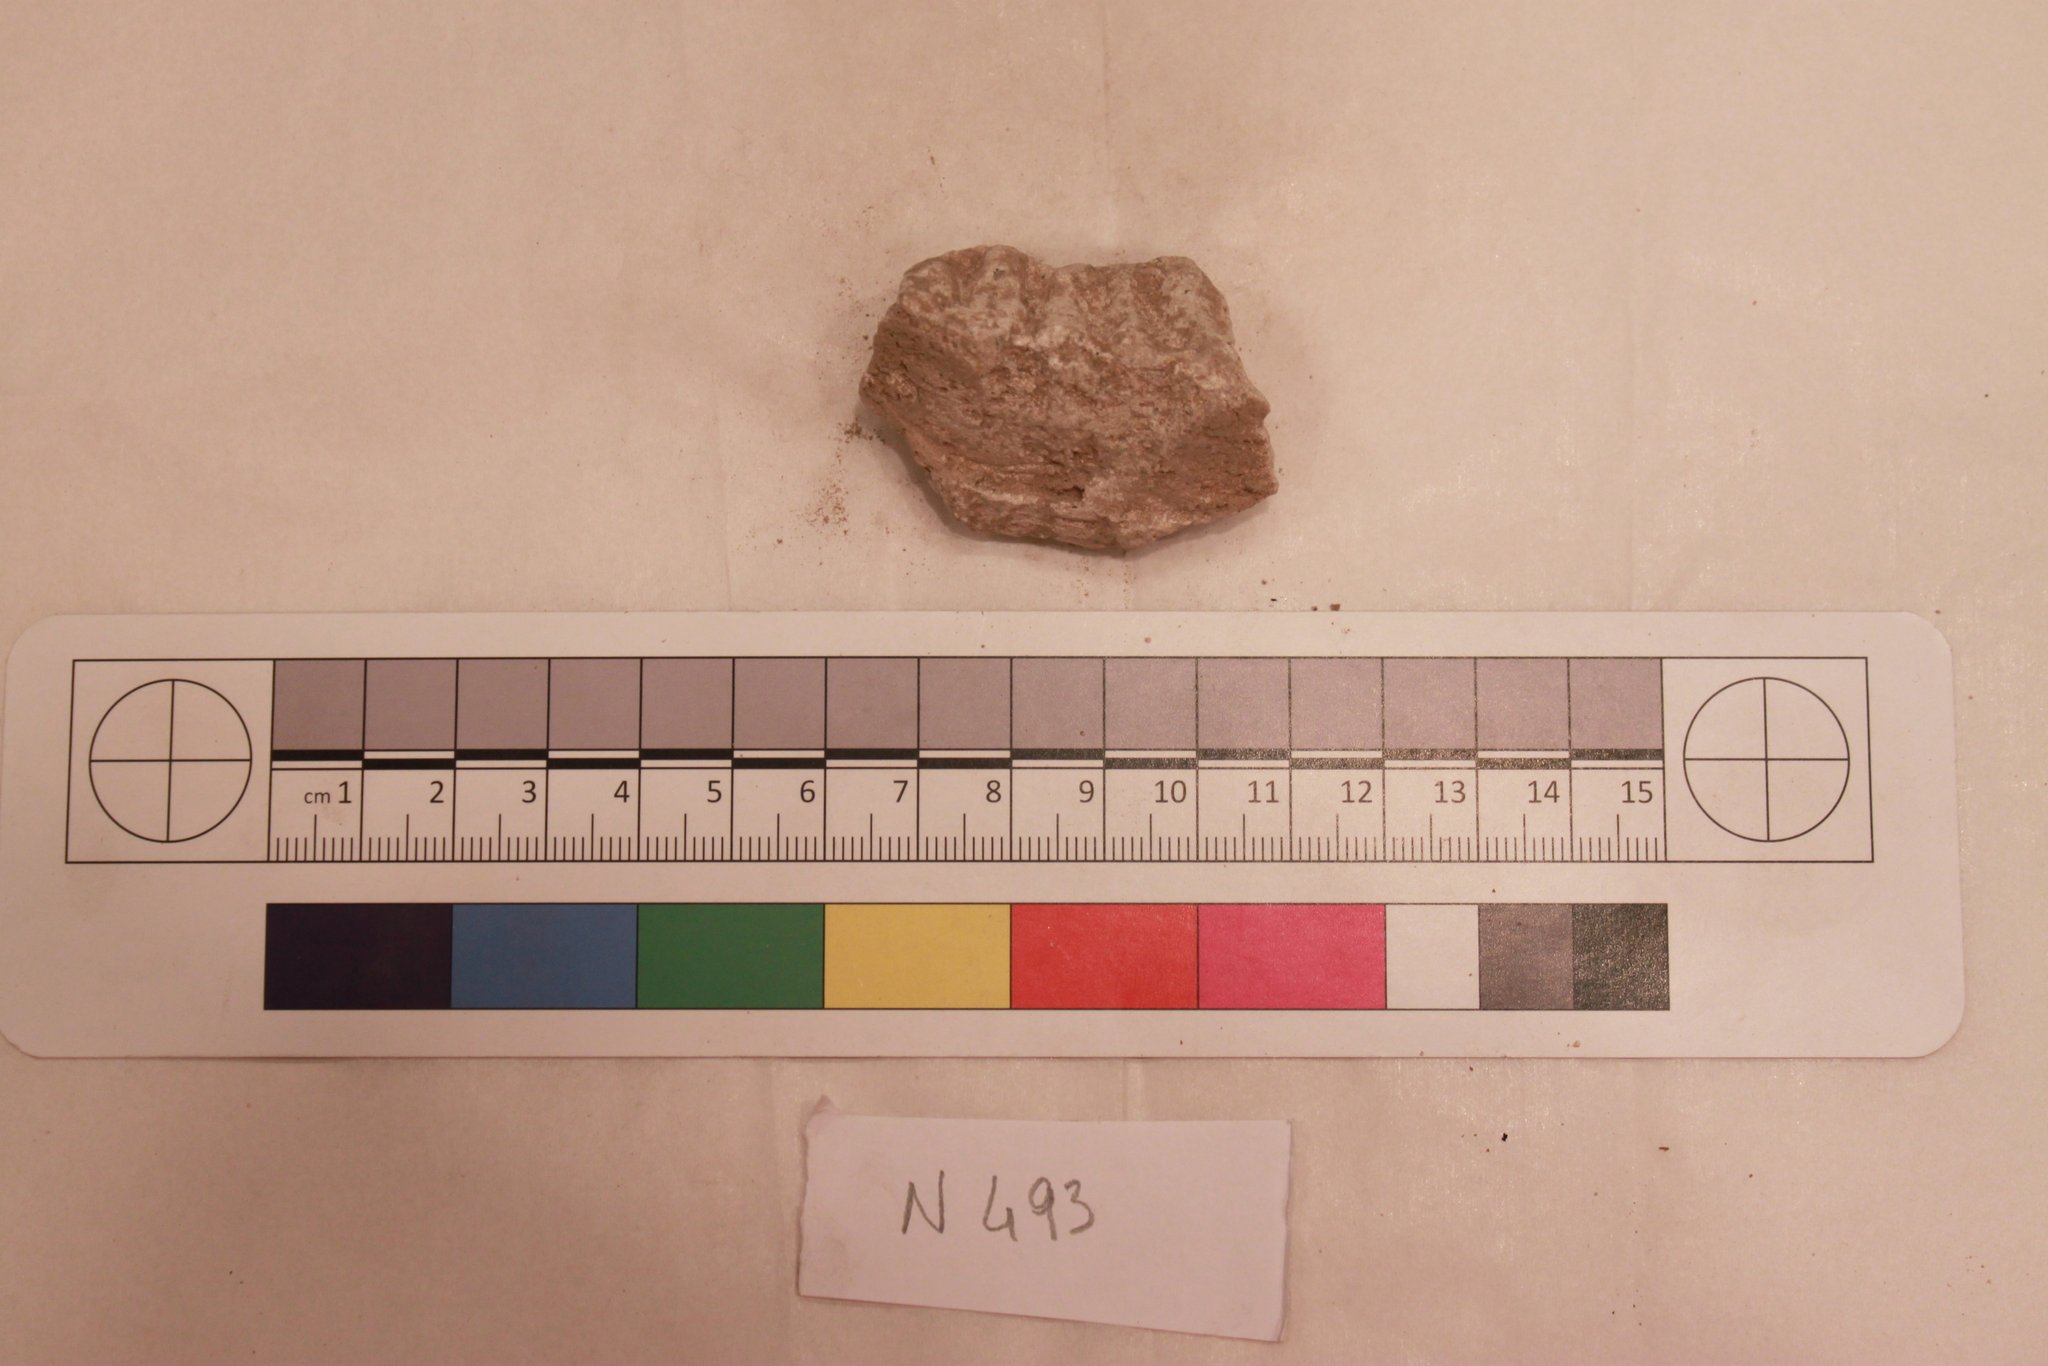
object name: fragment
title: Stucco Fragment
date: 701-1200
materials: plaster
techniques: carving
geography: iran